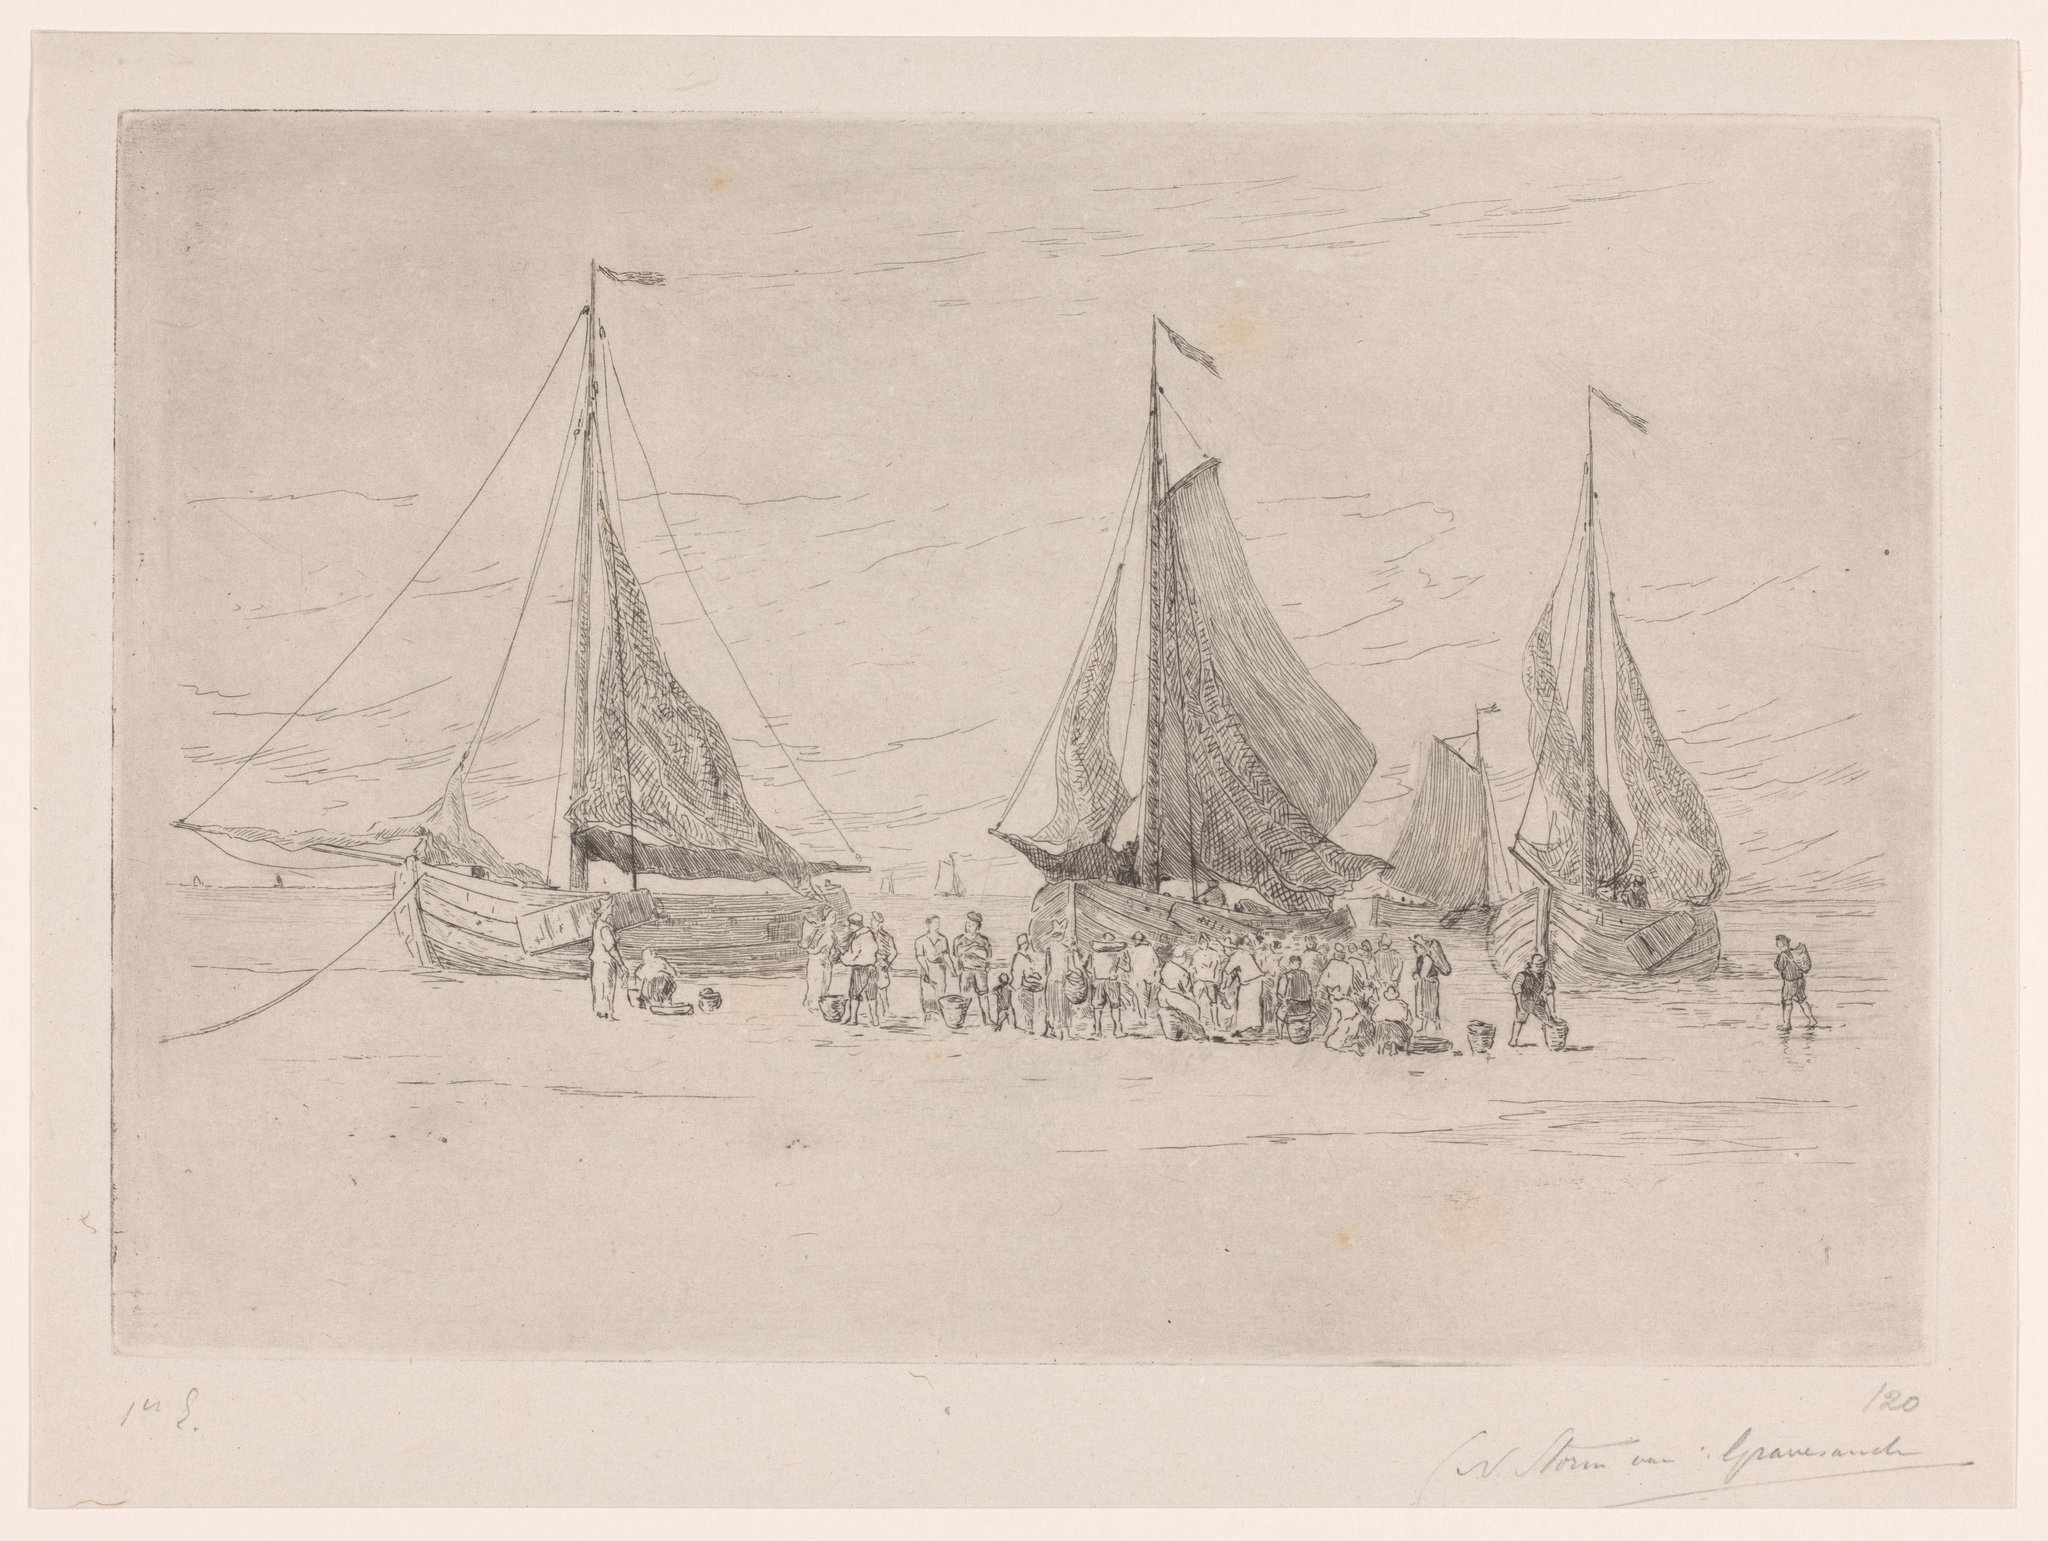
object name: print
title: Visverkoop op het strand van Zandvoort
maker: carel nicolaas storm van s-gravesande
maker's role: draughtsman, print maker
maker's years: 1841-1924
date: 1880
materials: paper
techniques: etching, intaglio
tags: commercial fishery, buying and selling, beach (+ landscape with figures, staffage)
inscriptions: collector's mark: Lugt 2228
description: In de branding liggen vissersboten. Daarvoor staat een groep mensen vis te verhandelen.